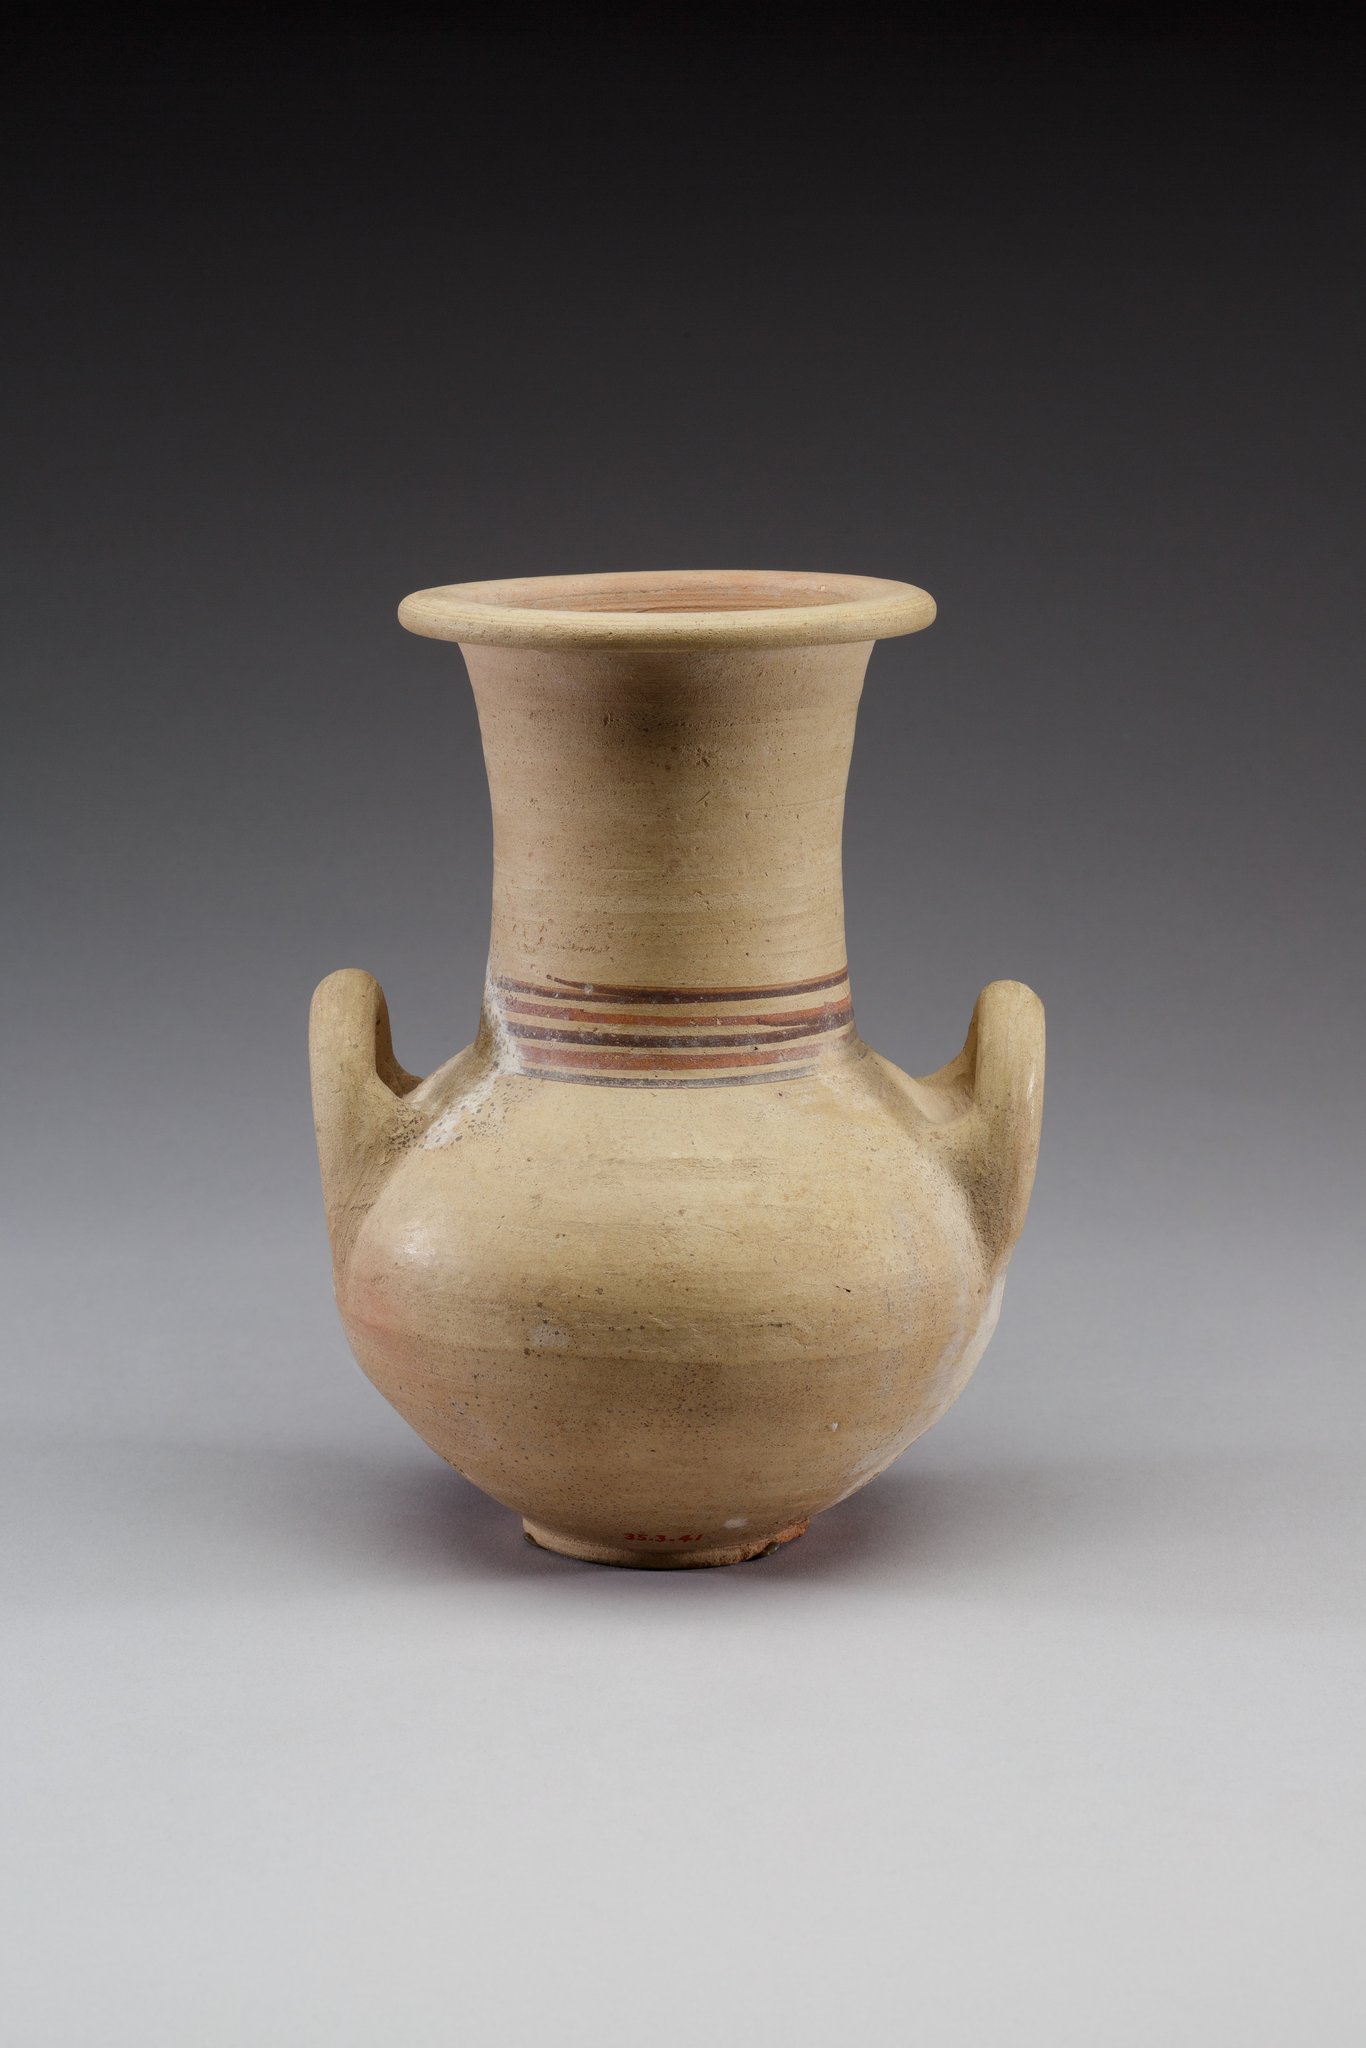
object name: jar, two handled, ruiu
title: Two-Handled Jar from the Burial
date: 1504-1447 BCE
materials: pottery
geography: egypt